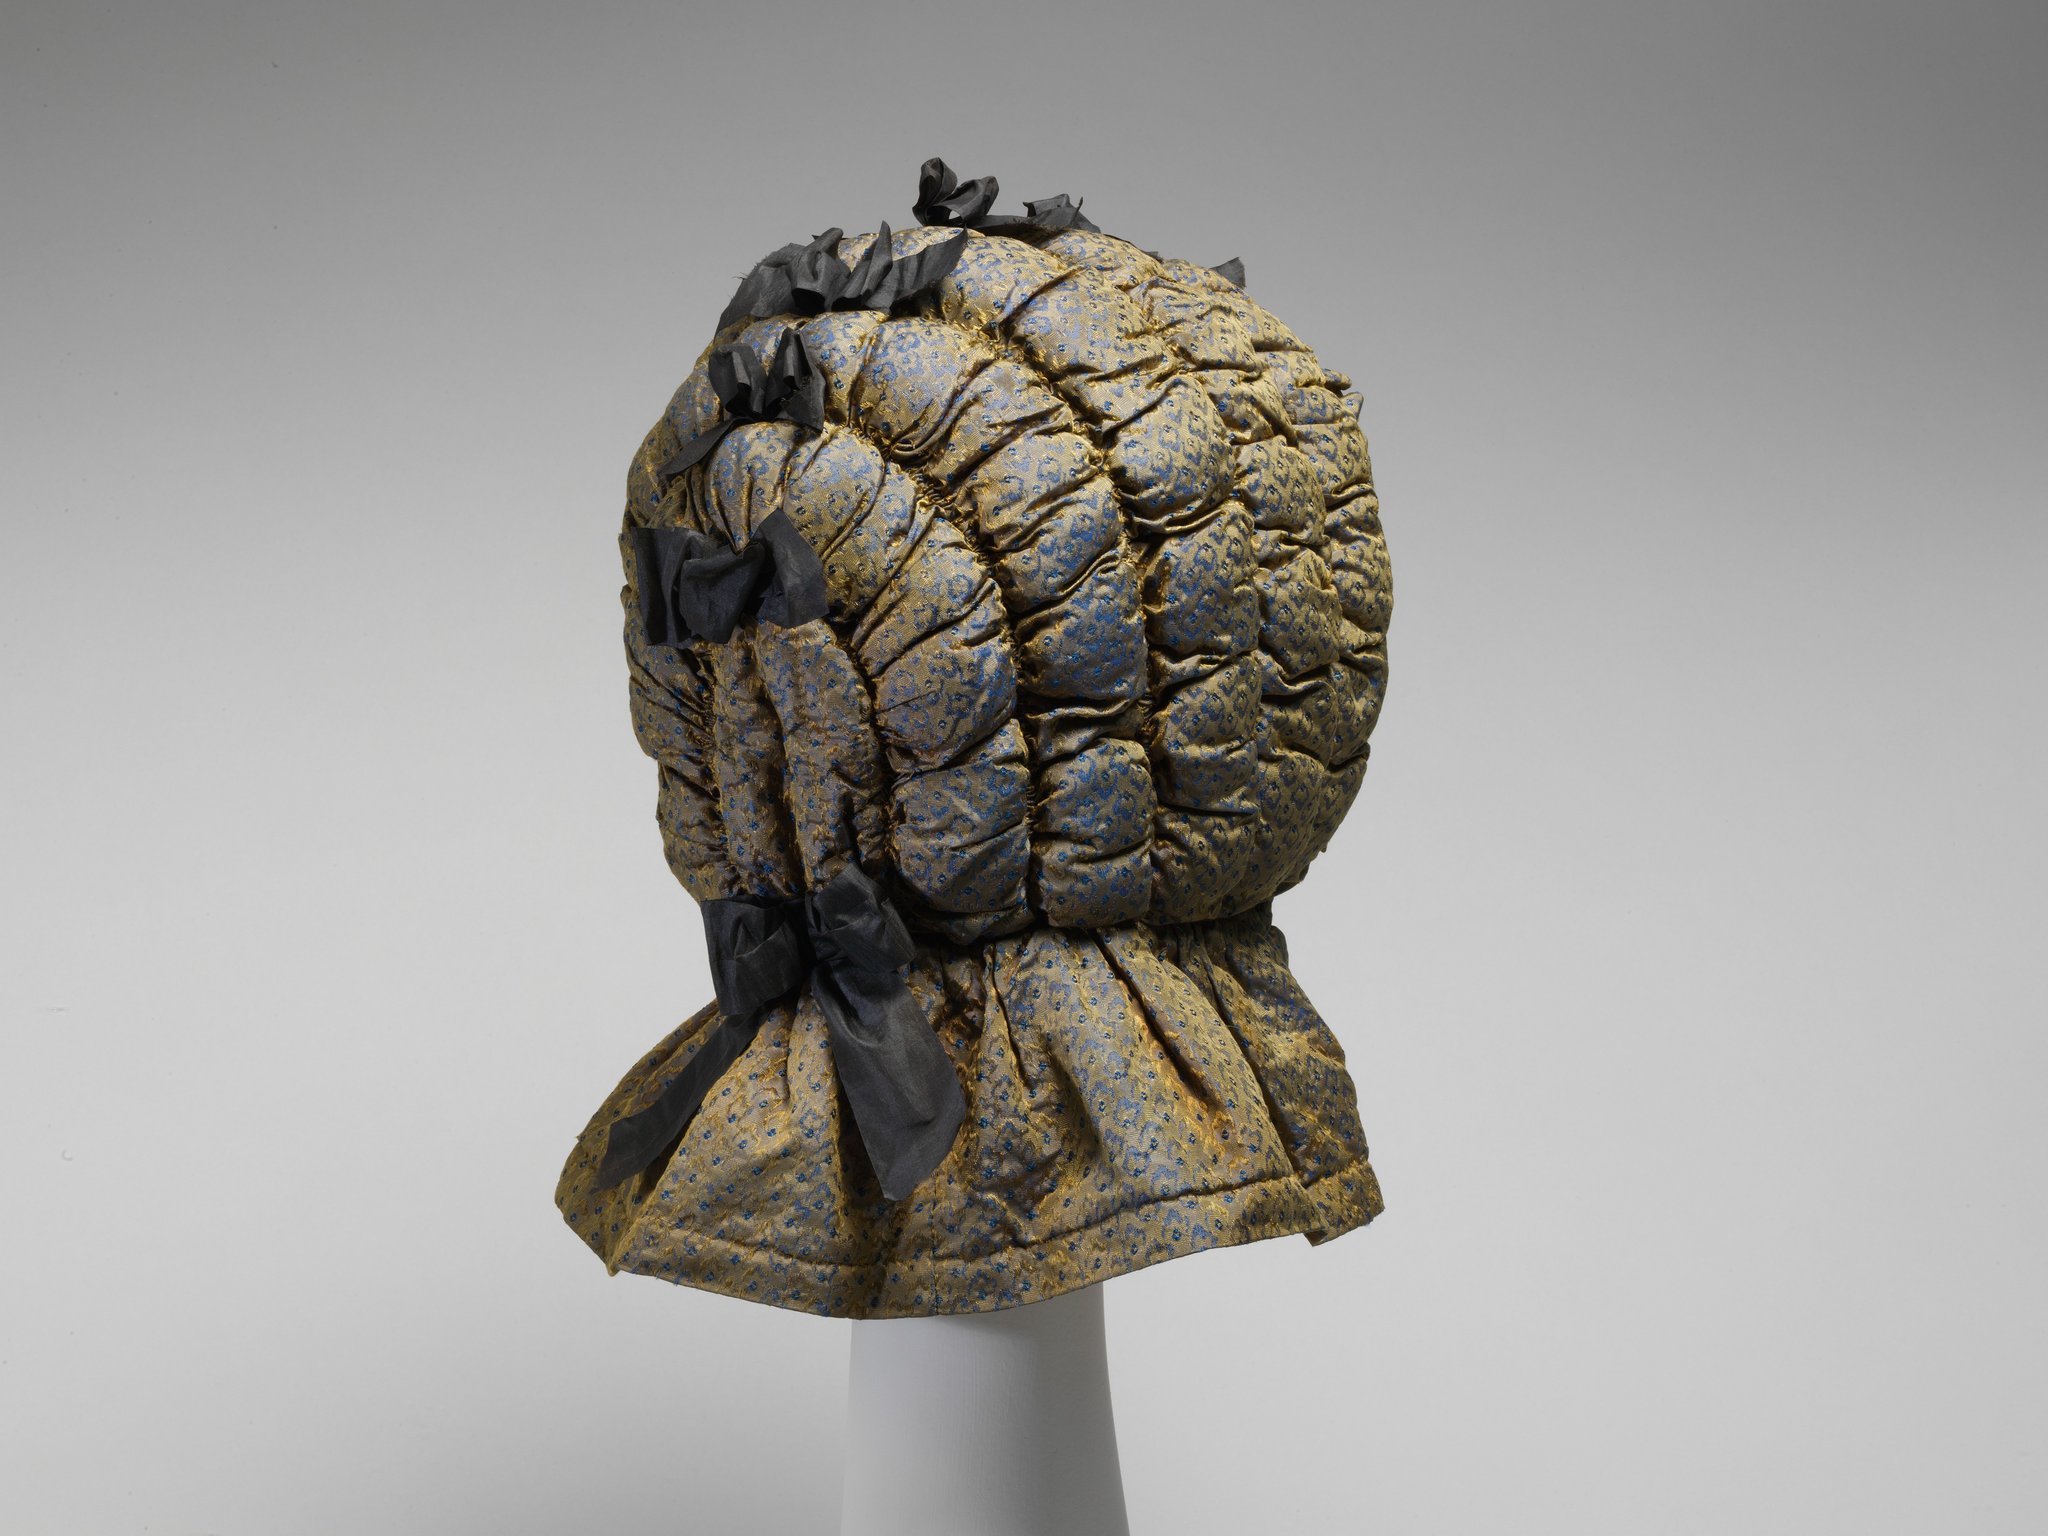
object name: bonnet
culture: american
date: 1840-1849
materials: linen, silk